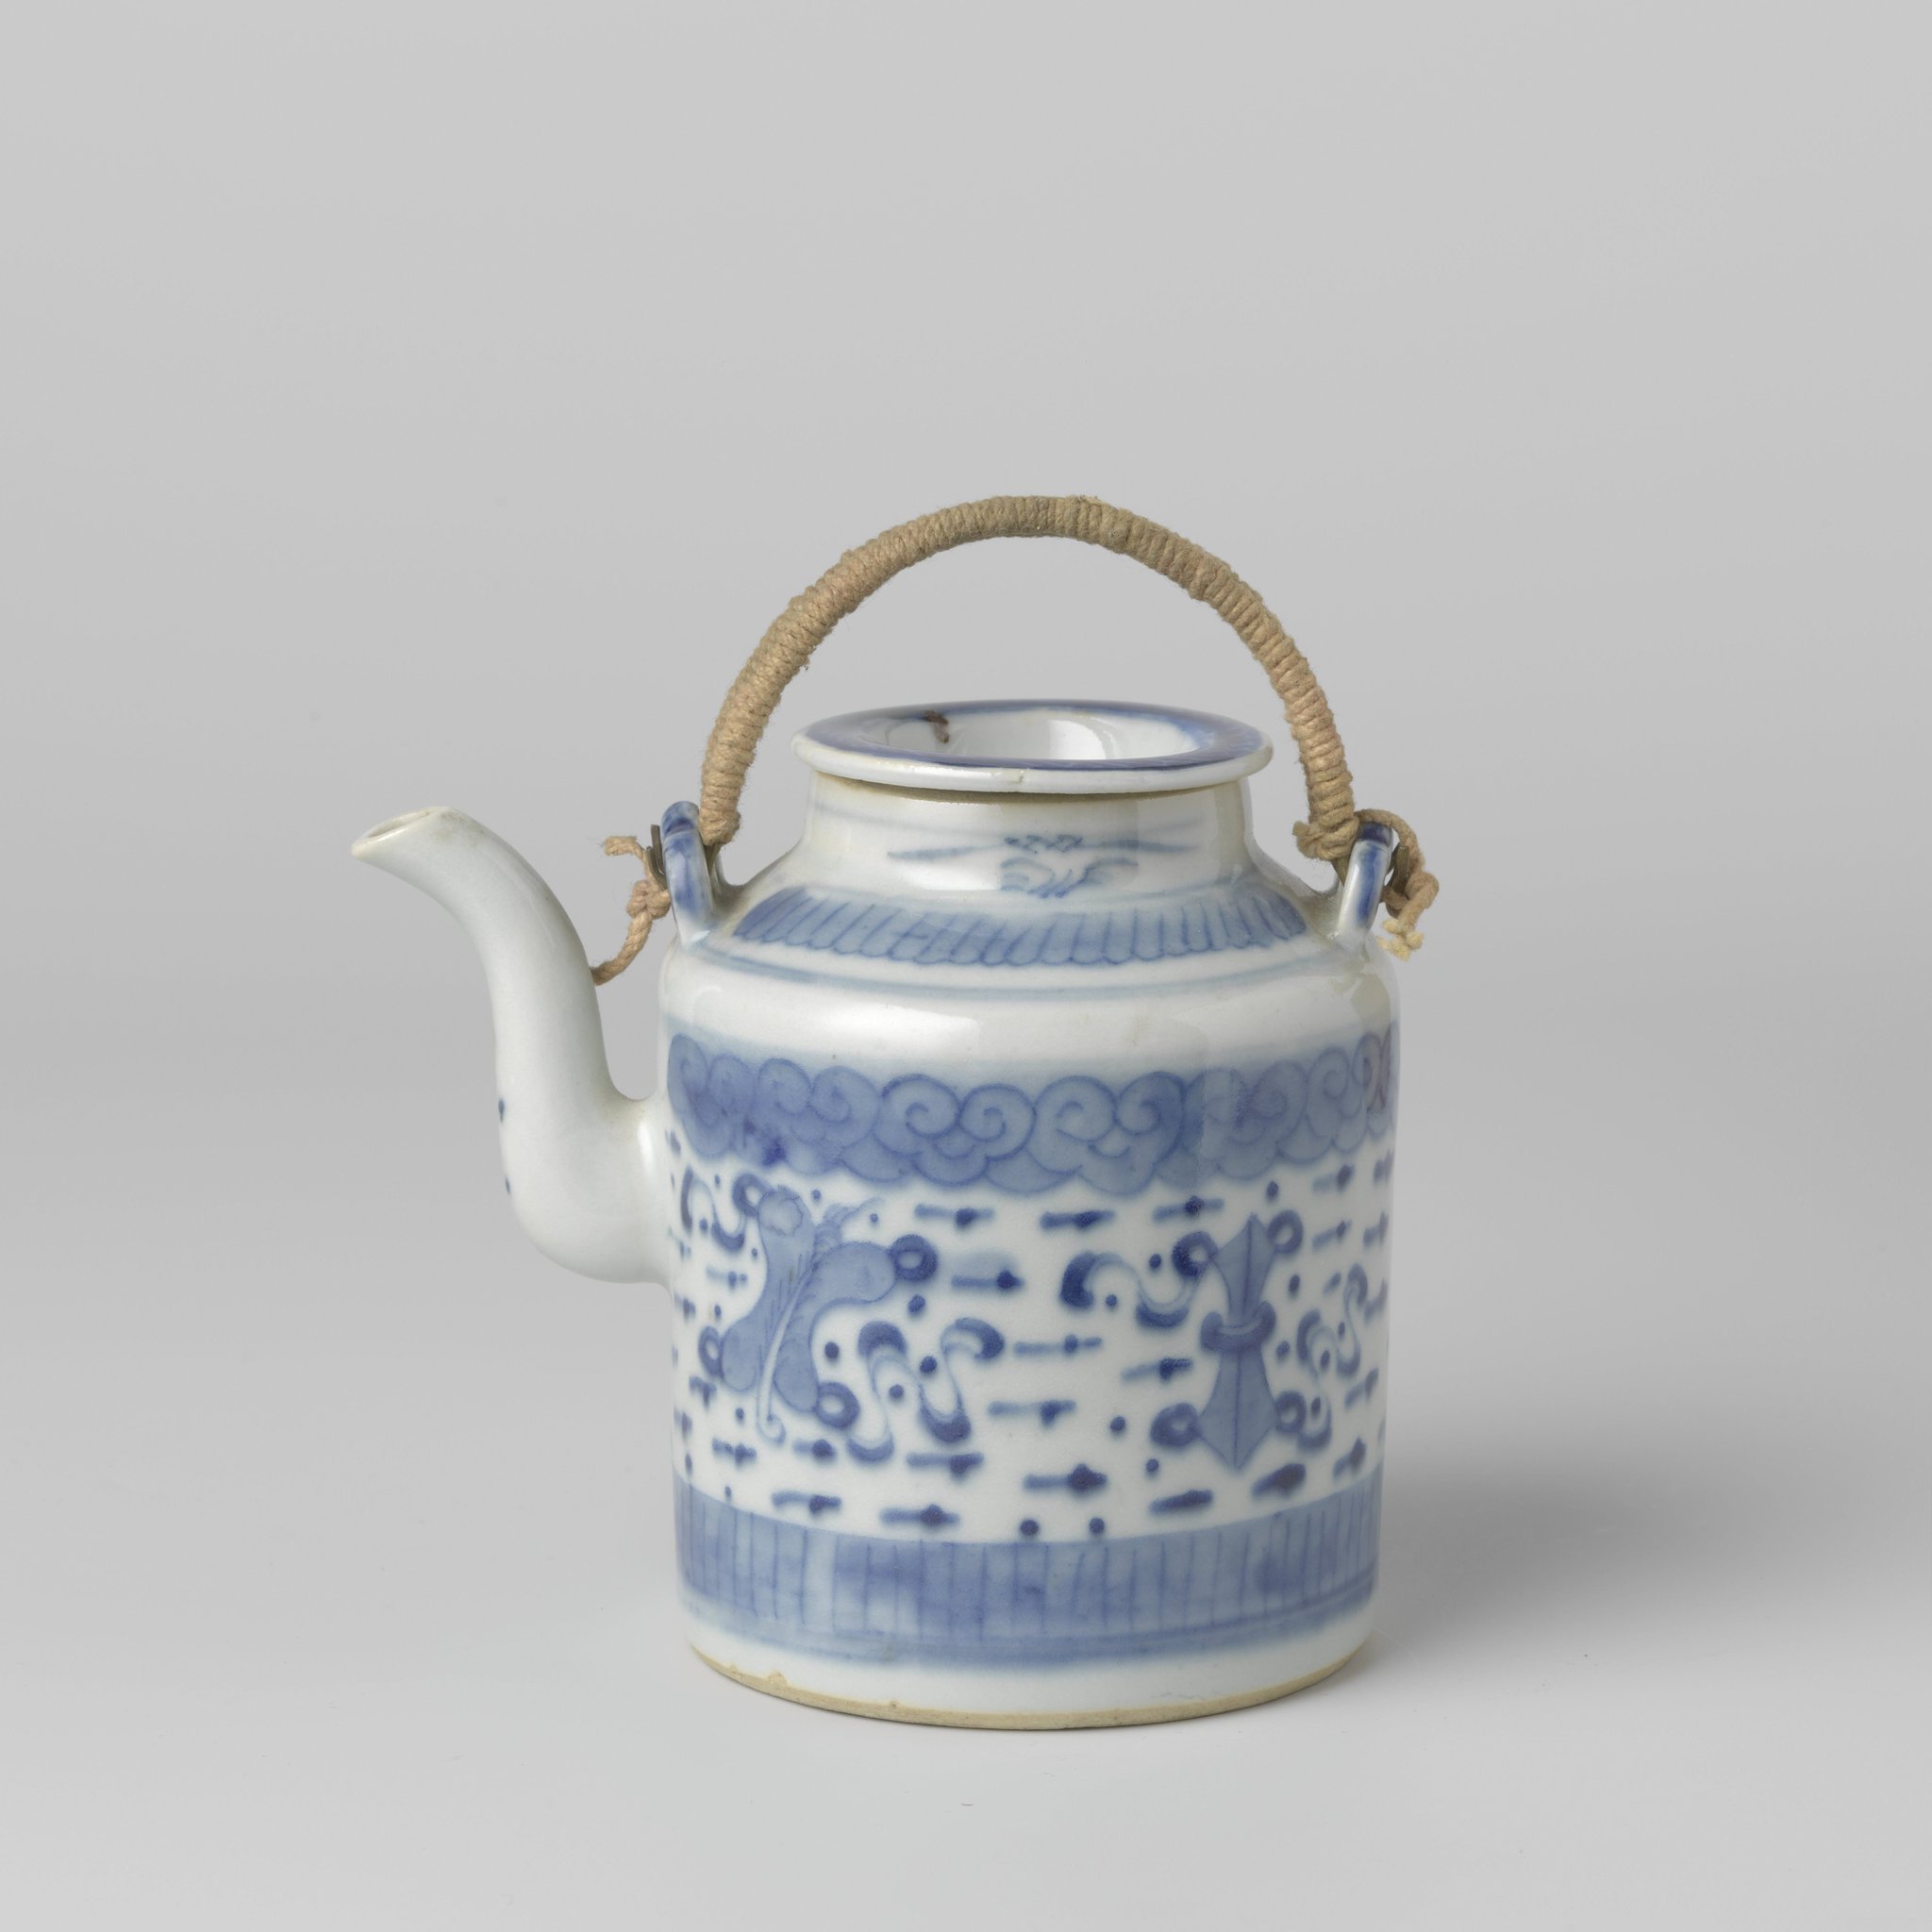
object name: teapot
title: Teapot with precious objects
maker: Anonymous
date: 1800-1999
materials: cobalt, copper, glaze, iron, paint, porcelain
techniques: braiding, firing, forming, turning, vitrification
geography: china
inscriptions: inscription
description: Cilindervormige theepot van porselein met tuit en handvat van omwikkeld ijzerdraad, beschilderd in onderglazuur blauw. Op de wand twee decoratieve banden met hiertussen kostbaarheden (boeken), gelukssymbolen (vaas) en taoïstische symbolen (waaier, castagnetten). Blauw-wit.